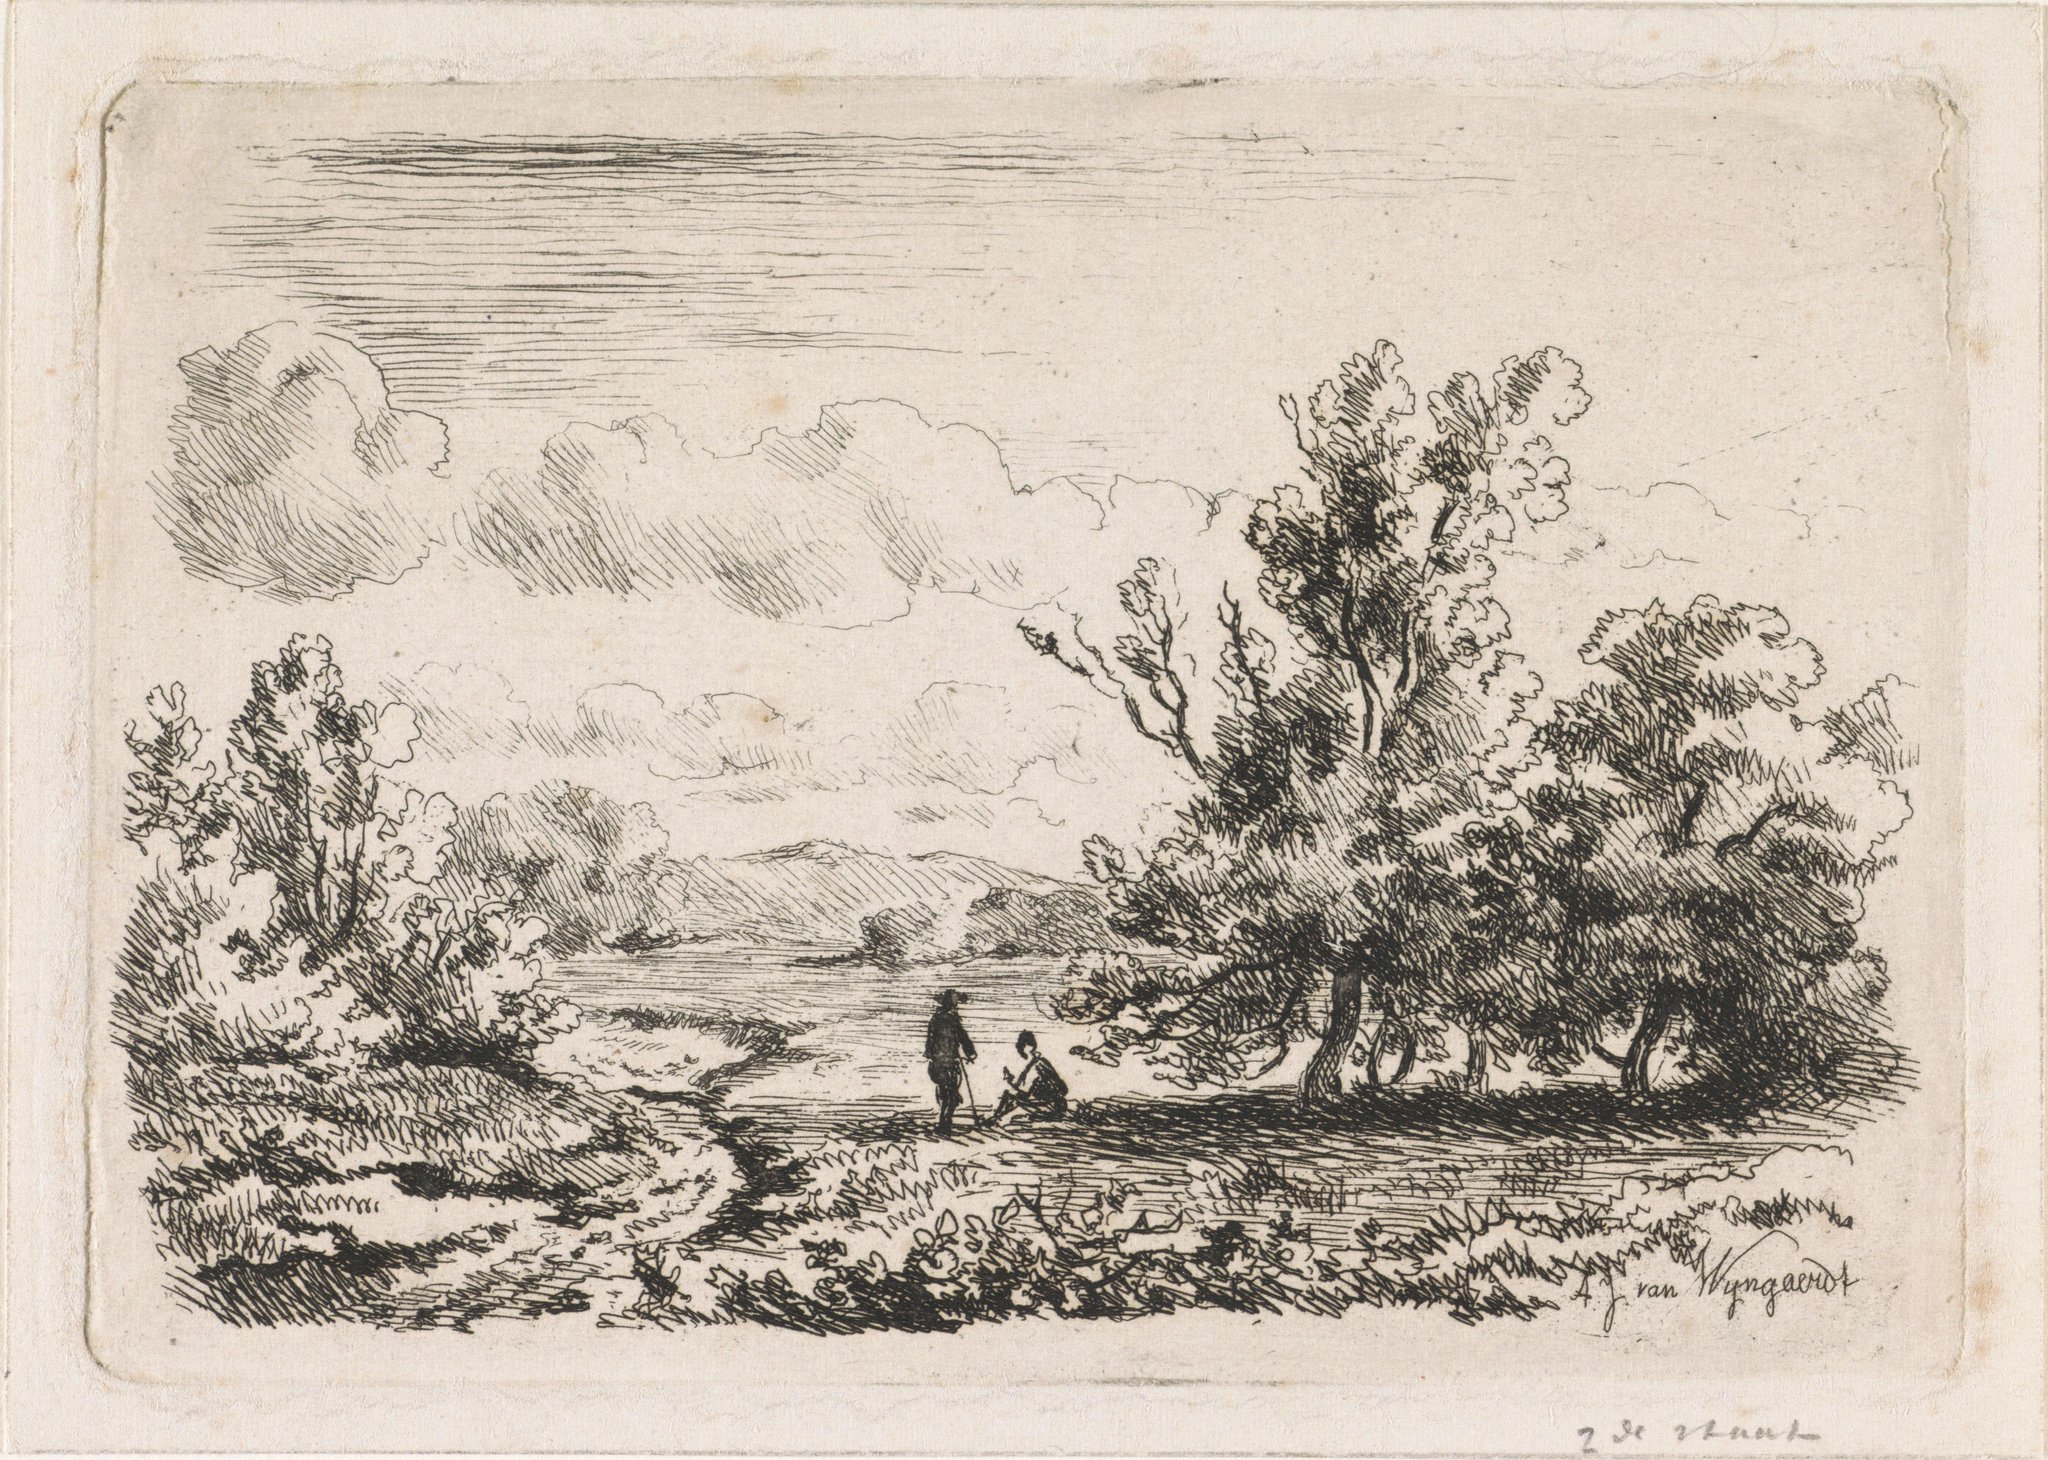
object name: print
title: Rivierlandschap met twee figuren onder een boom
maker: anthonie jacobus van wijngaerdt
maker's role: print maker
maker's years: 1808-1887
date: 1818-1882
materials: paper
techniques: etching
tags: river (+ landscape with figures, staffage)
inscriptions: collector's mark: Lugt 2228